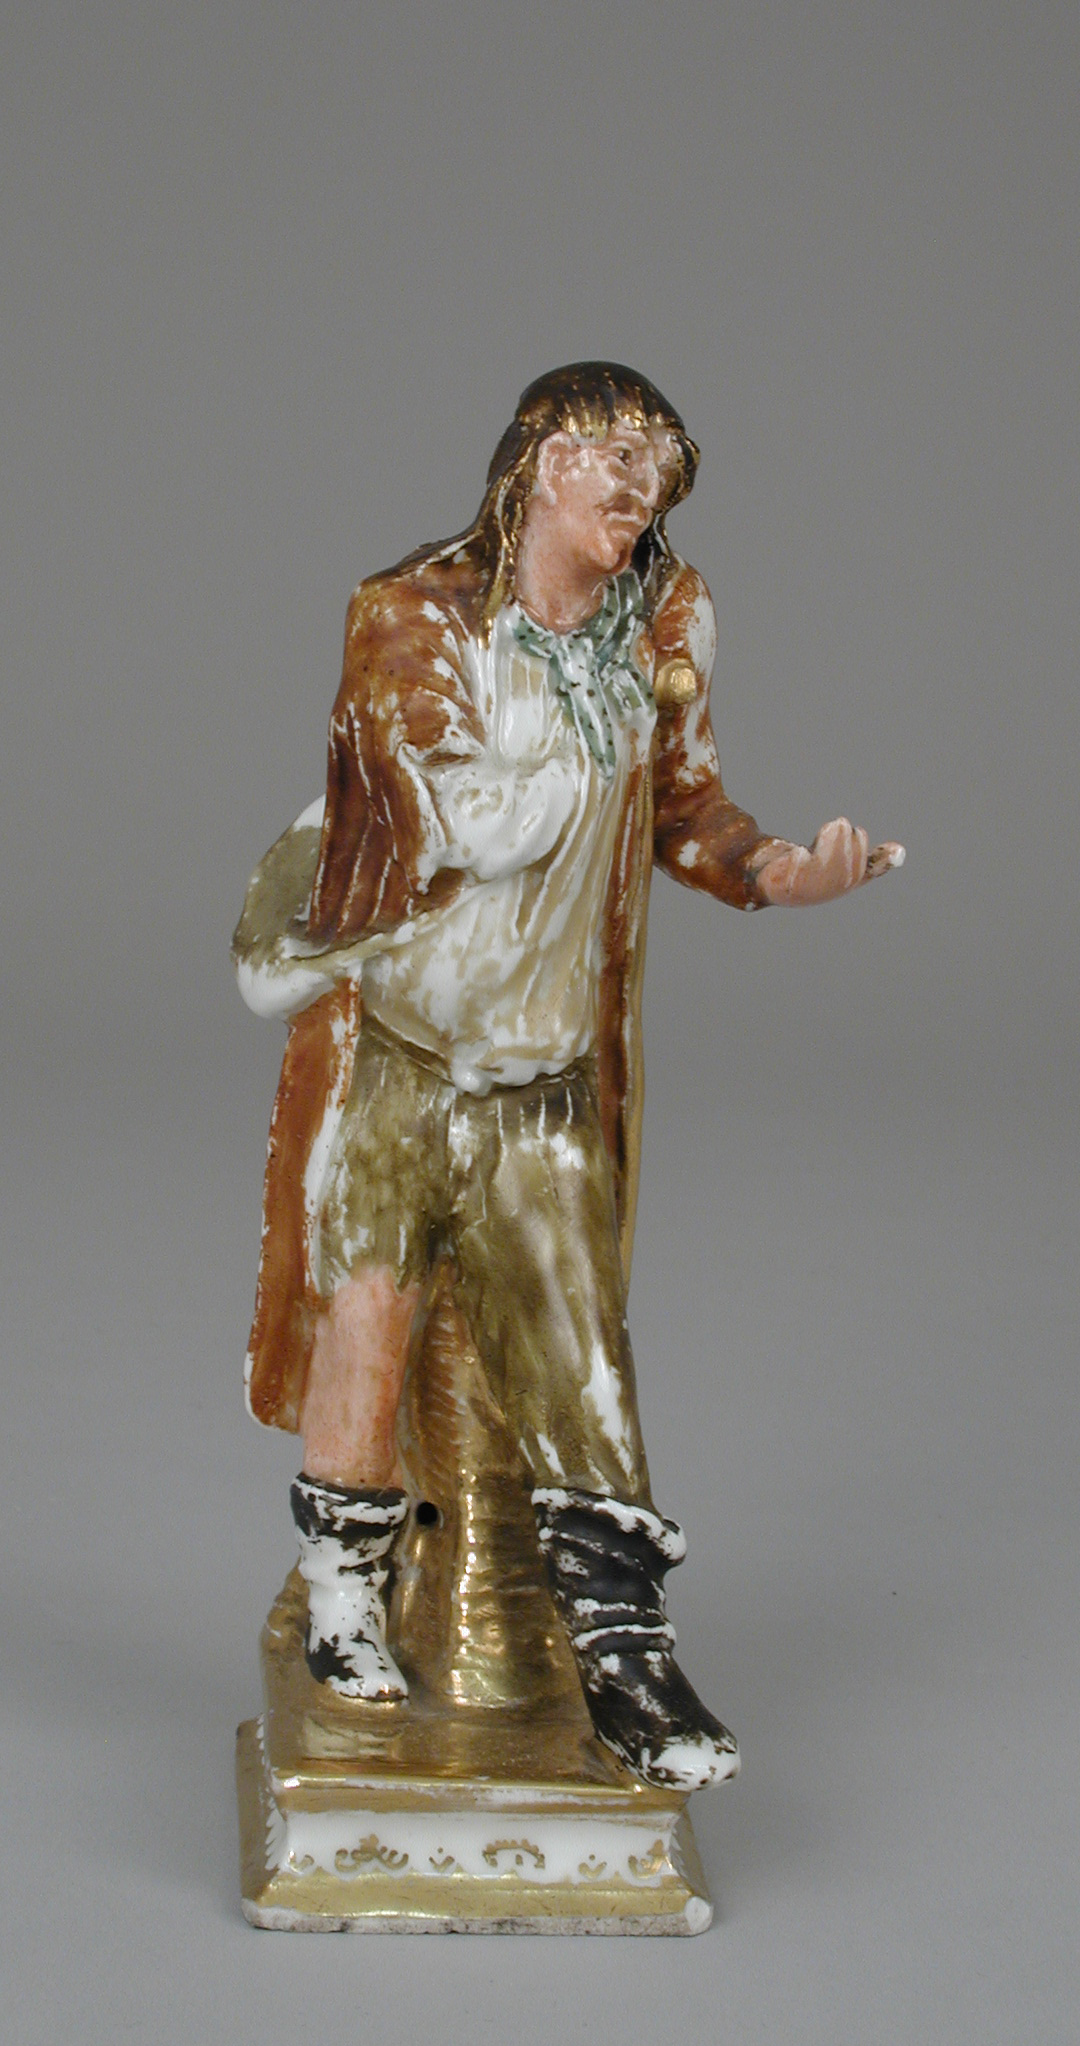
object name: figure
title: Beggar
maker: meissen manufactory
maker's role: manufactory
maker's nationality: german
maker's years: 1710-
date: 1733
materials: hard paste porcelain, silver gilt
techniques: painting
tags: men